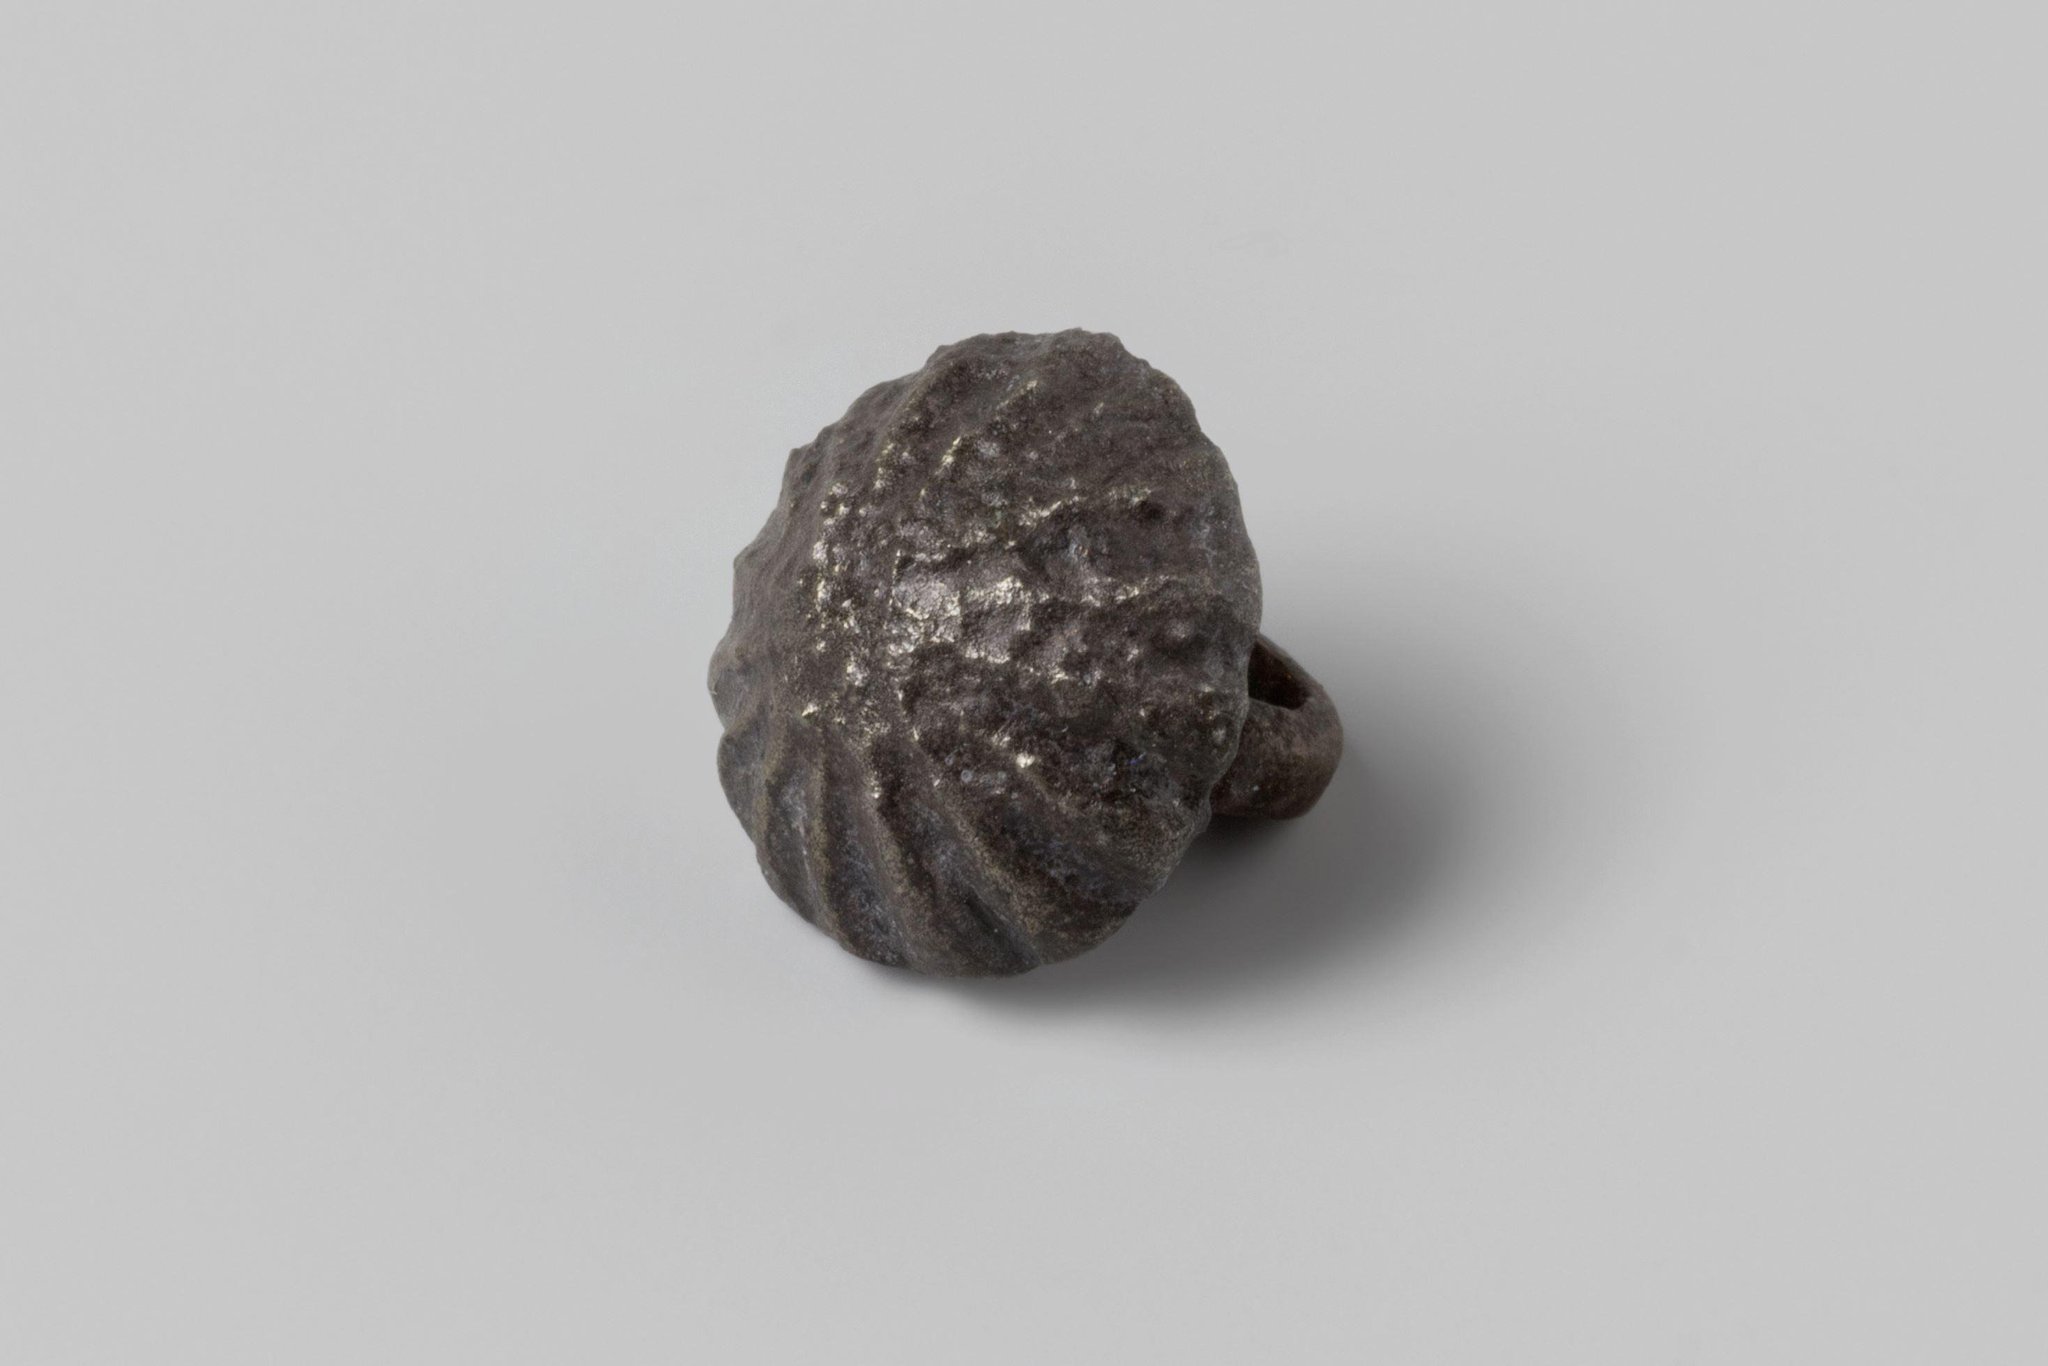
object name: button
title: Knoop uit het wrak van de Oost-Indiëvaarder Hollandia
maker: Anonymous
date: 1700-1743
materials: copper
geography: netherlands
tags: verenigde oostindische compagnie, hollandia (schip), annet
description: Knoop. Button; conical, radially fluted, lead-filled, loop-shank.